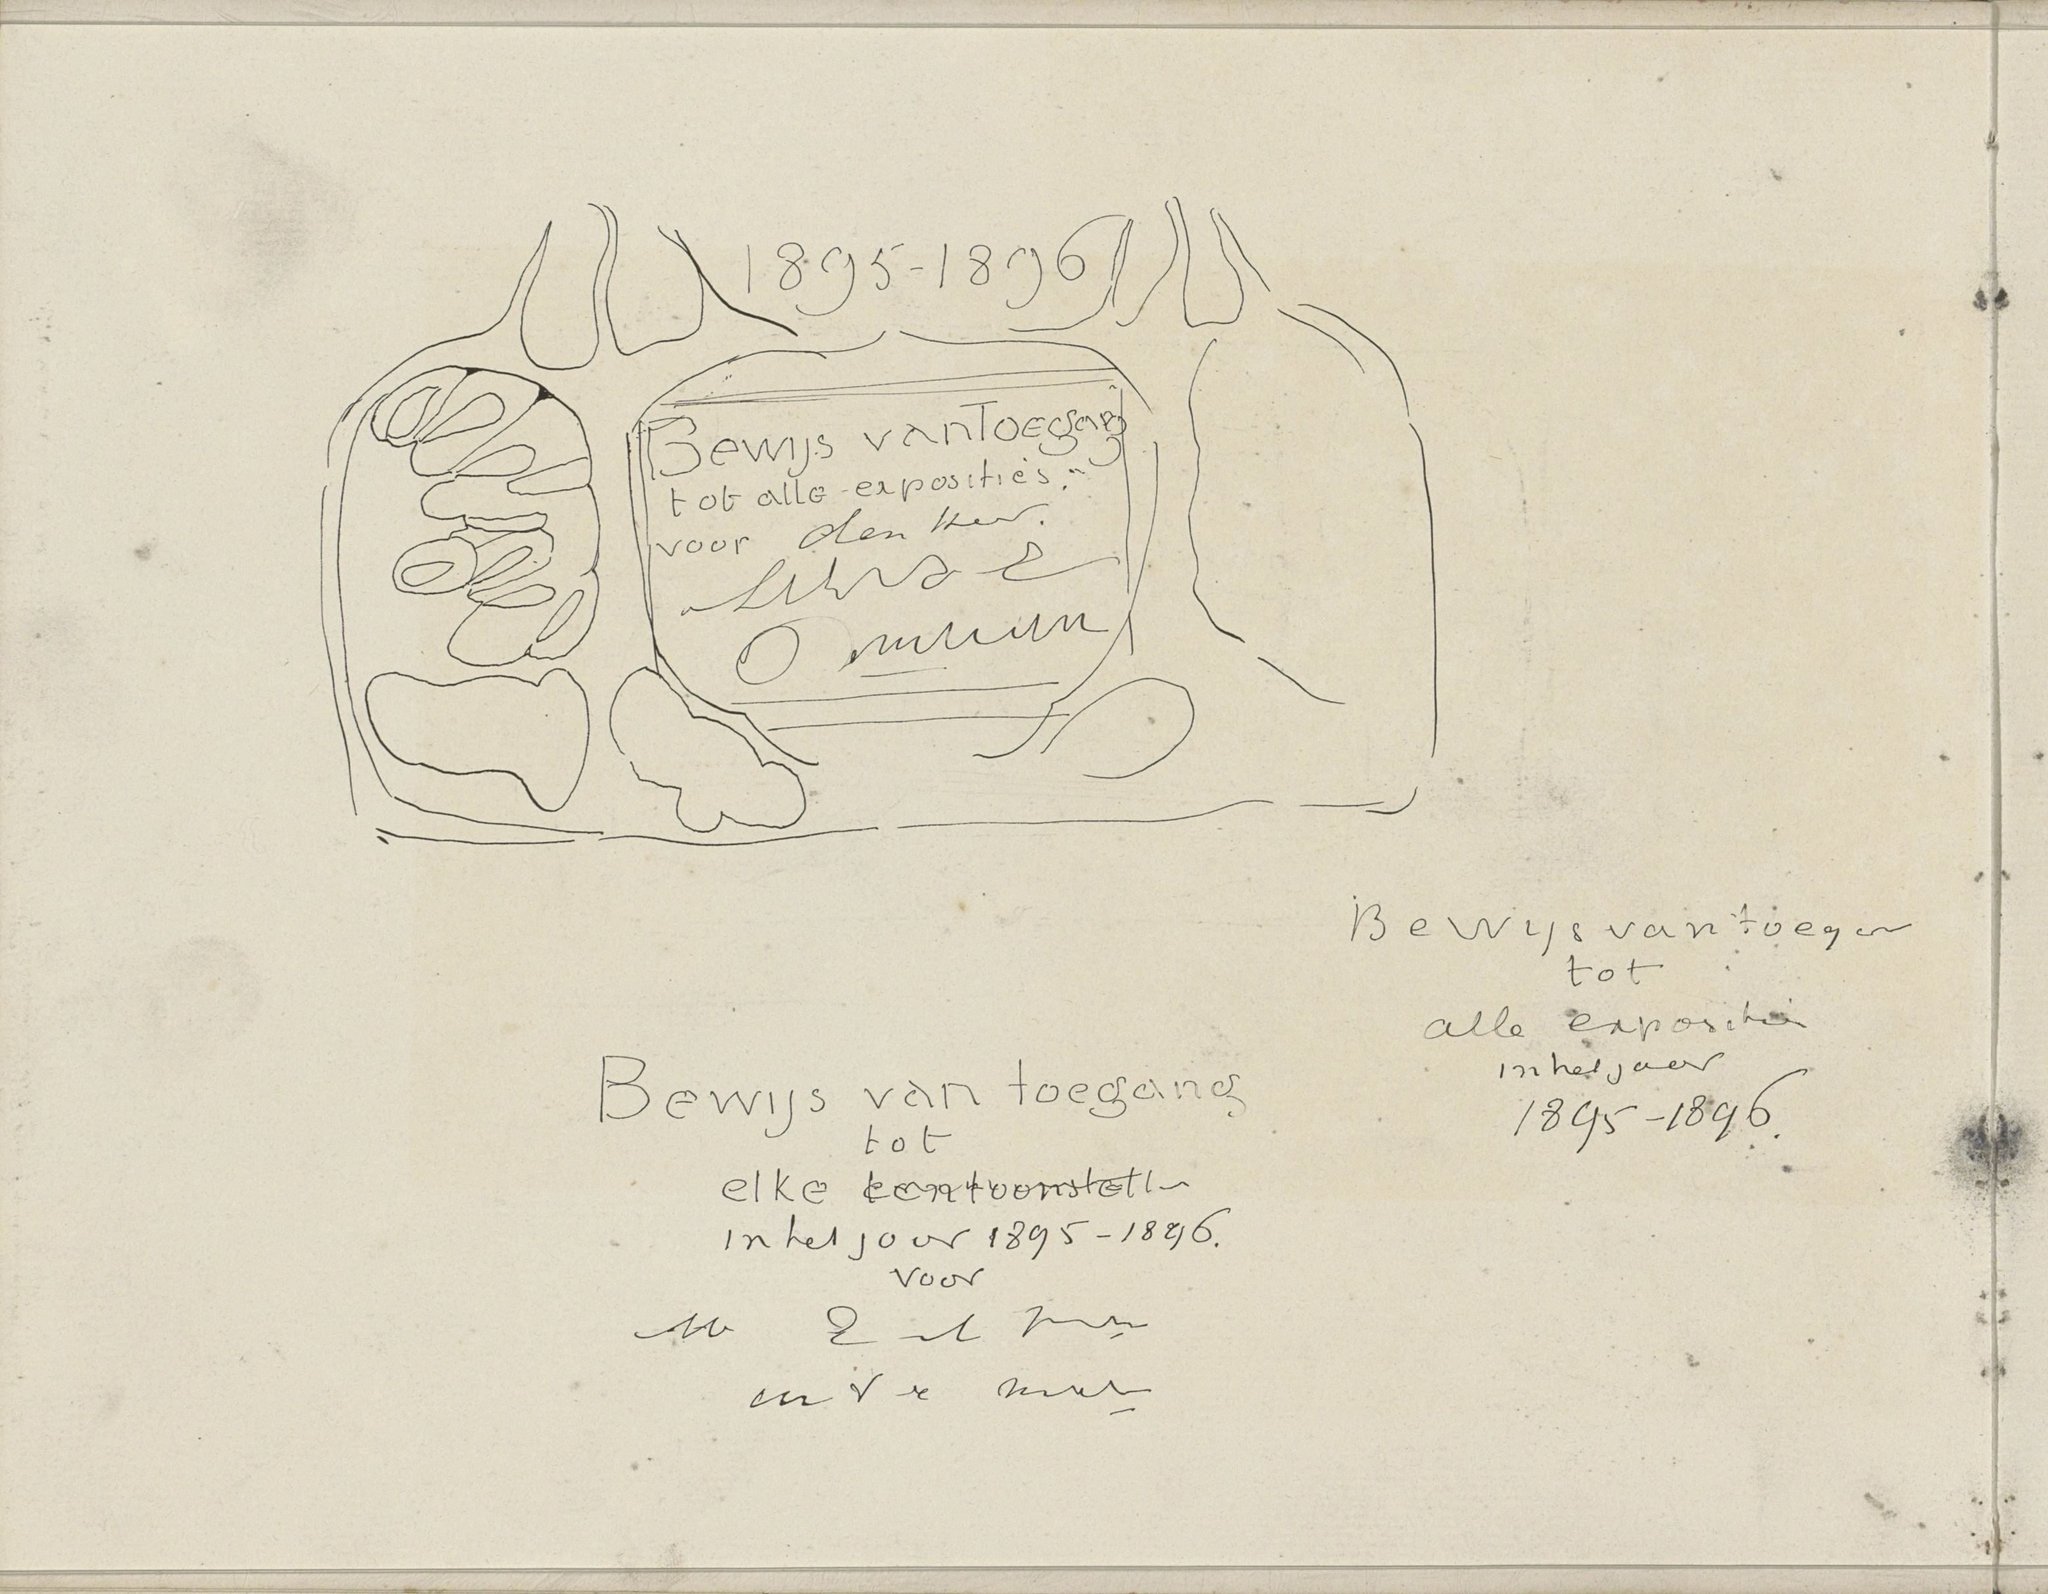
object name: sketchbook leaf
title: Ontwerp voor een bewijs van toegang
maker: carel adolph lion cachet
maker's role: draughtsman, print maker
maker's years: 1864-1945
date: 1896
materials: ink, paper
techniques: pen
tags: letters, alphabet, script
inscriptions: annotation: ‘1895-1896/ Bewijs van toegang/ tot alle exposities/ voor den Heer/ [...]/ Bewijs van toegang/ tot/ elke tentoonstell/ in het jaar 1895-1896/ voor/ Bewijs van toegang/ tot alle exposities/ in het jaar 1895-1896’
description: Blad 25 verso uit een schetsboek met 44 bladen.